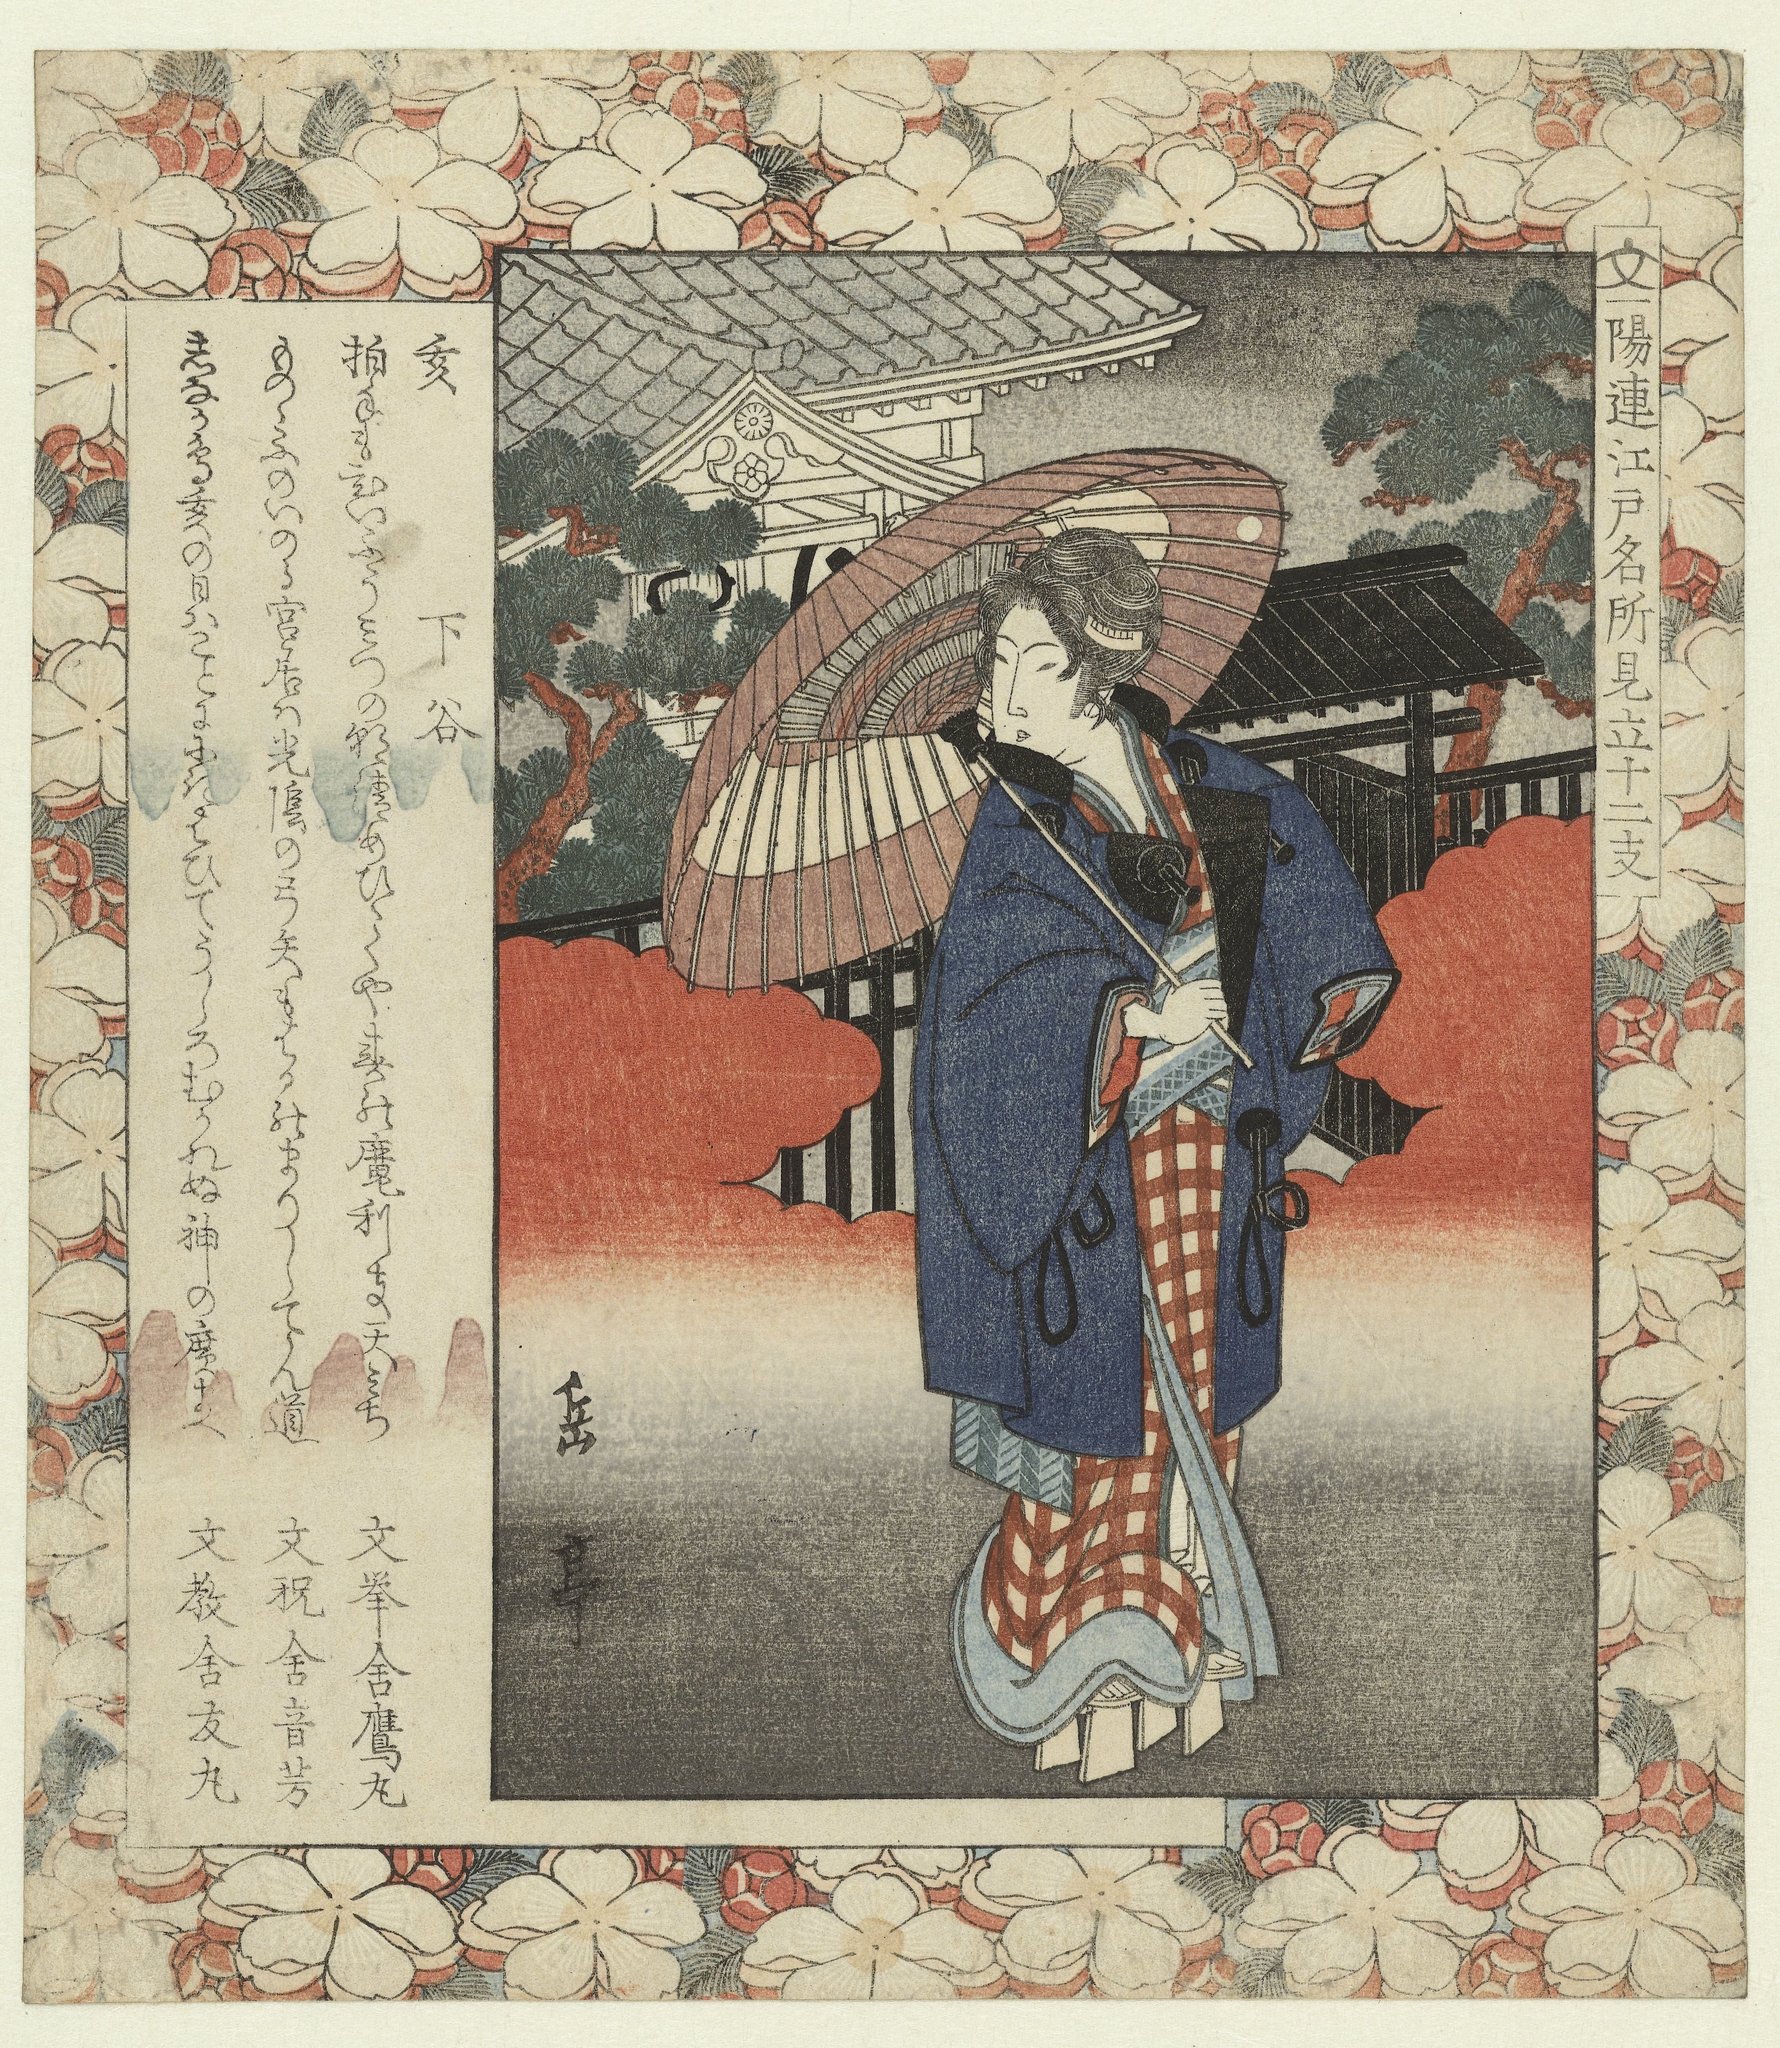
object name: surimono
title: Everzwijn: Shitaya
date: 1827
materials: paper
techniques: blind stamped, woodcut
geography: japan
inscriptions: collector's mark, verso, stamped: Lugt 2228, collector's mark, passe-partout, bottom left, printed: JABdH with a rooster.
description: Een surimono is een luxe uitgevoerde prent waarop beeld met één of meerdere gedichten gecombineerd is. Bij het drukken van een surimono werd vaak gebruik gemaakt van dikker papier, blinddruk en metaal pigmenten, zoals koper- en zilverpoeder. De prenten werden vaak in opdracht van dichters gemaakt en als exclusief geschenk aan vrienden en relaties gegeven.